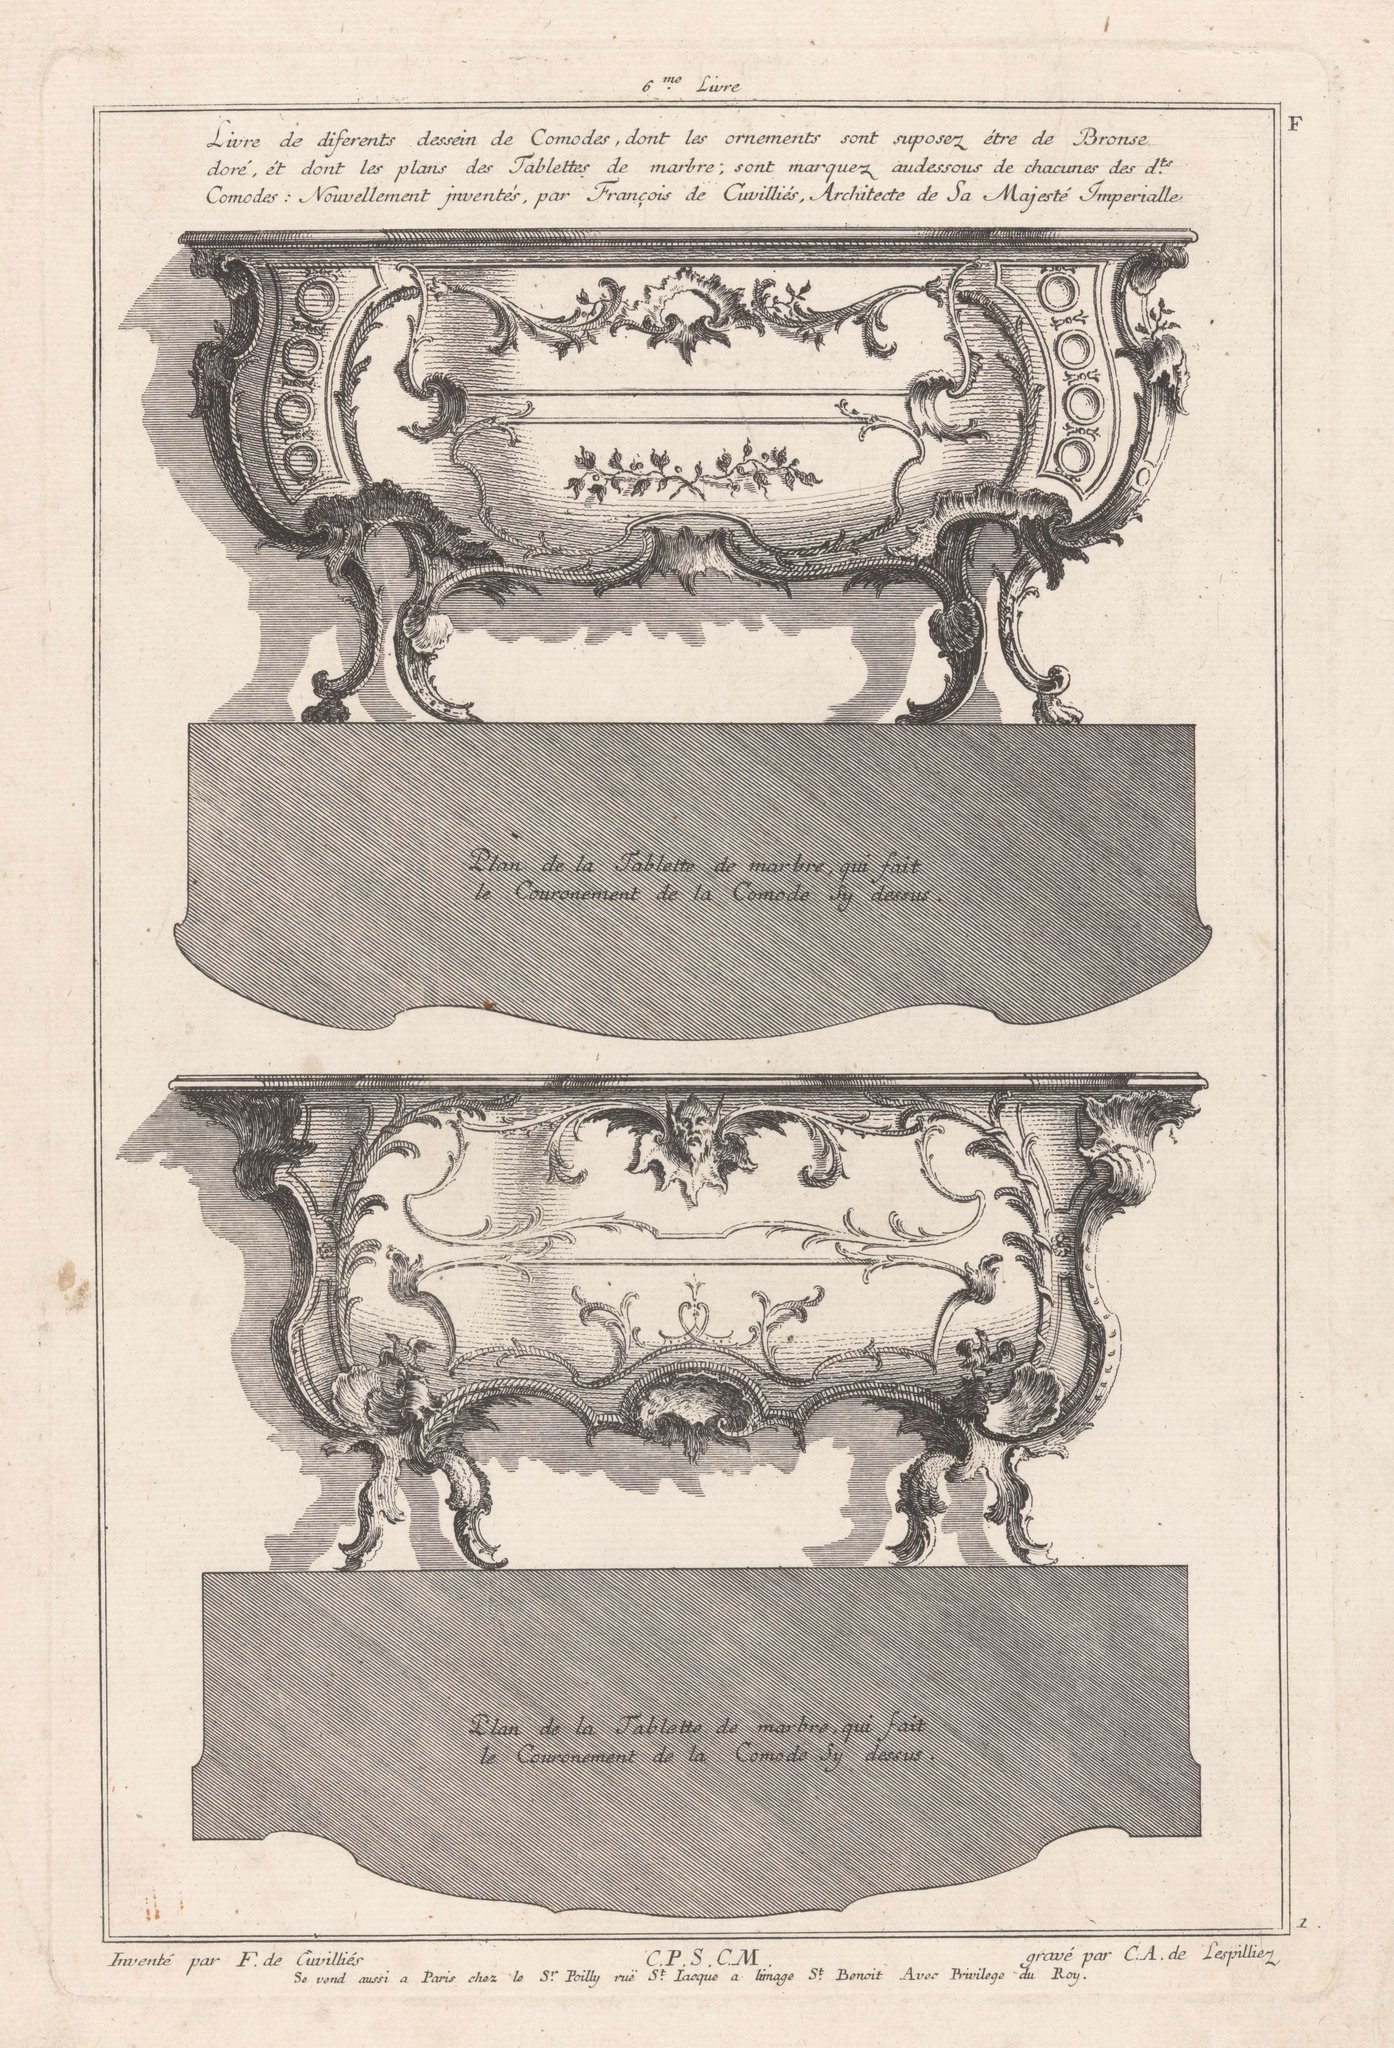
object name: ornament print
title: 6me Livre F Livre de diferents dessein de Comodes (...)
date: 1745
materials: paper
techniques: etching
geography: paris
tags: ornamental cupboard, mask, mascaron ~ ornament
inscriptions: collector's mark: Lugt 2760, collector's mark: Lugt 2228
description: Voor- en bovenaanzichten van twee geornamenteerde commodes met rocailles, onder met mannelijk masker met puntoren.